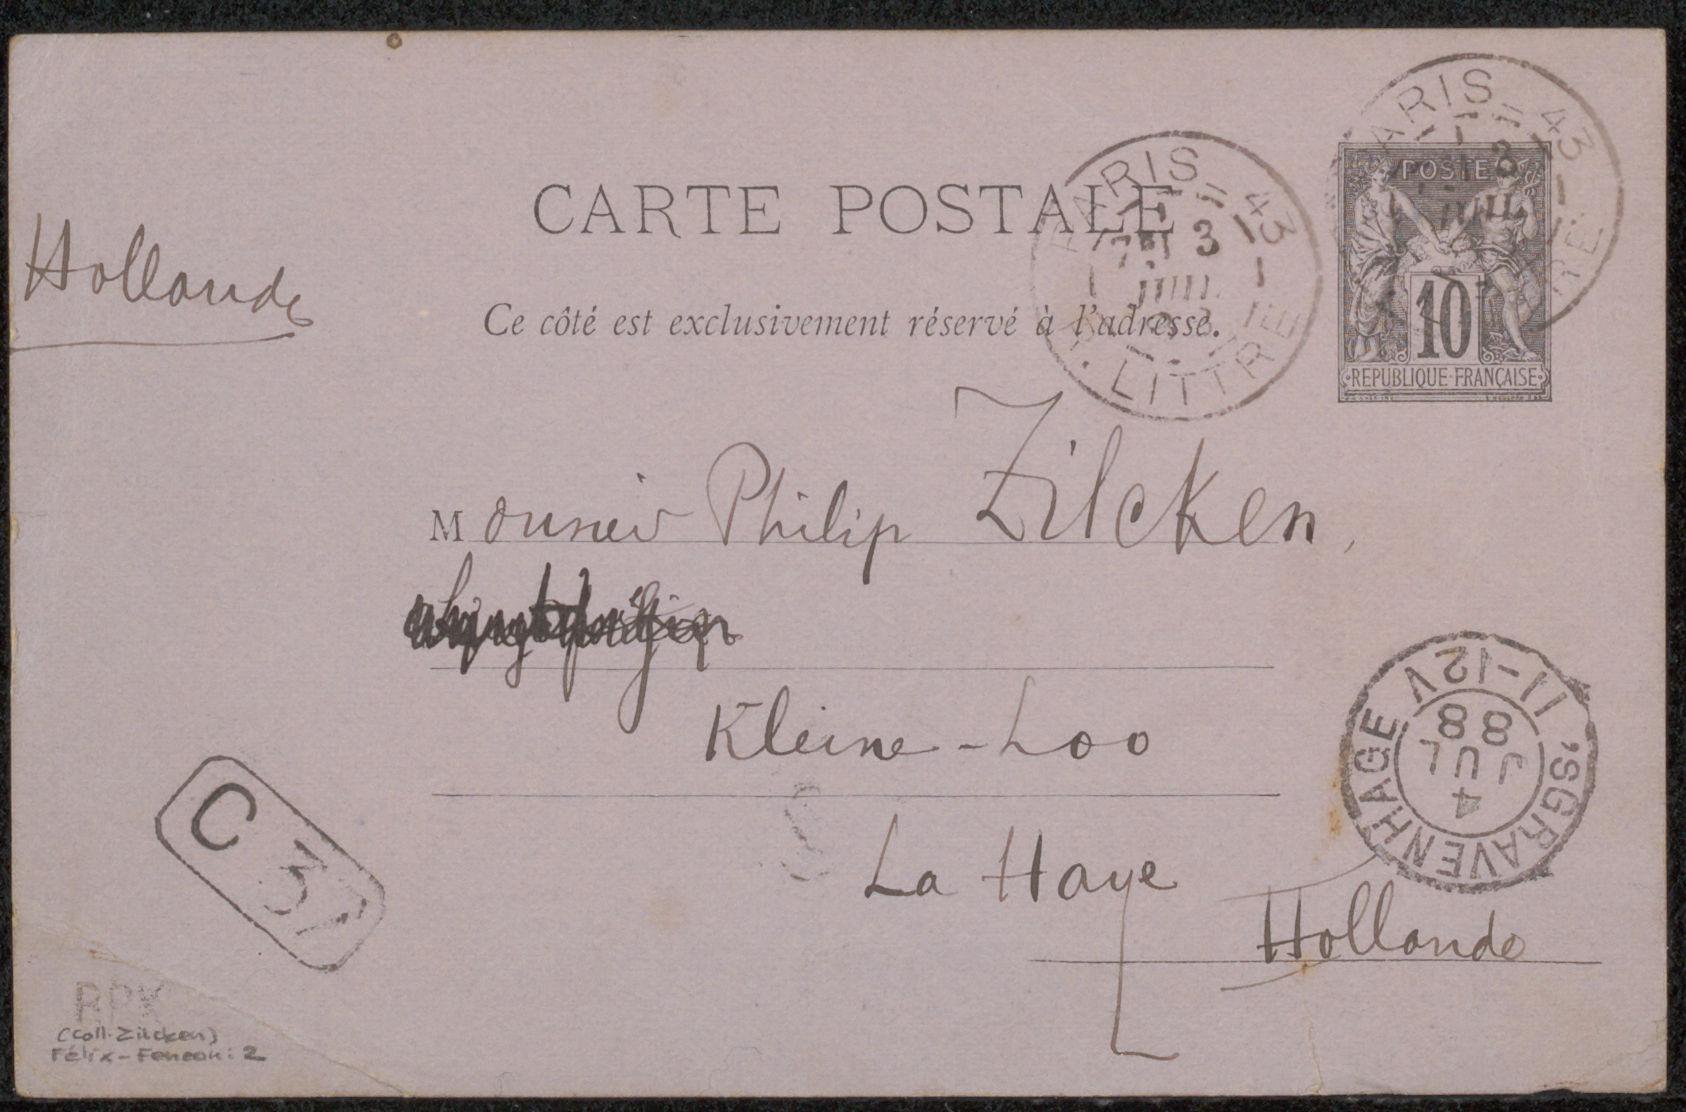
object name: postcard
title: Briefkaart aan Philip Zilcken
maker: félix fénéon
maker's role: handelaar, kunstcriticus, verzamelaar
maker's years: 1861-1944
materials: cardboard, ink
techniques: pen, writing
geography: paris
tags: antwerp, print maker, draughtsman, edouard dujardin, delft, johannes vermeer, the hague, philip zilcken, literature ~ arts, the graphic arts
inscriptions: collector's mark: ‘RPK’